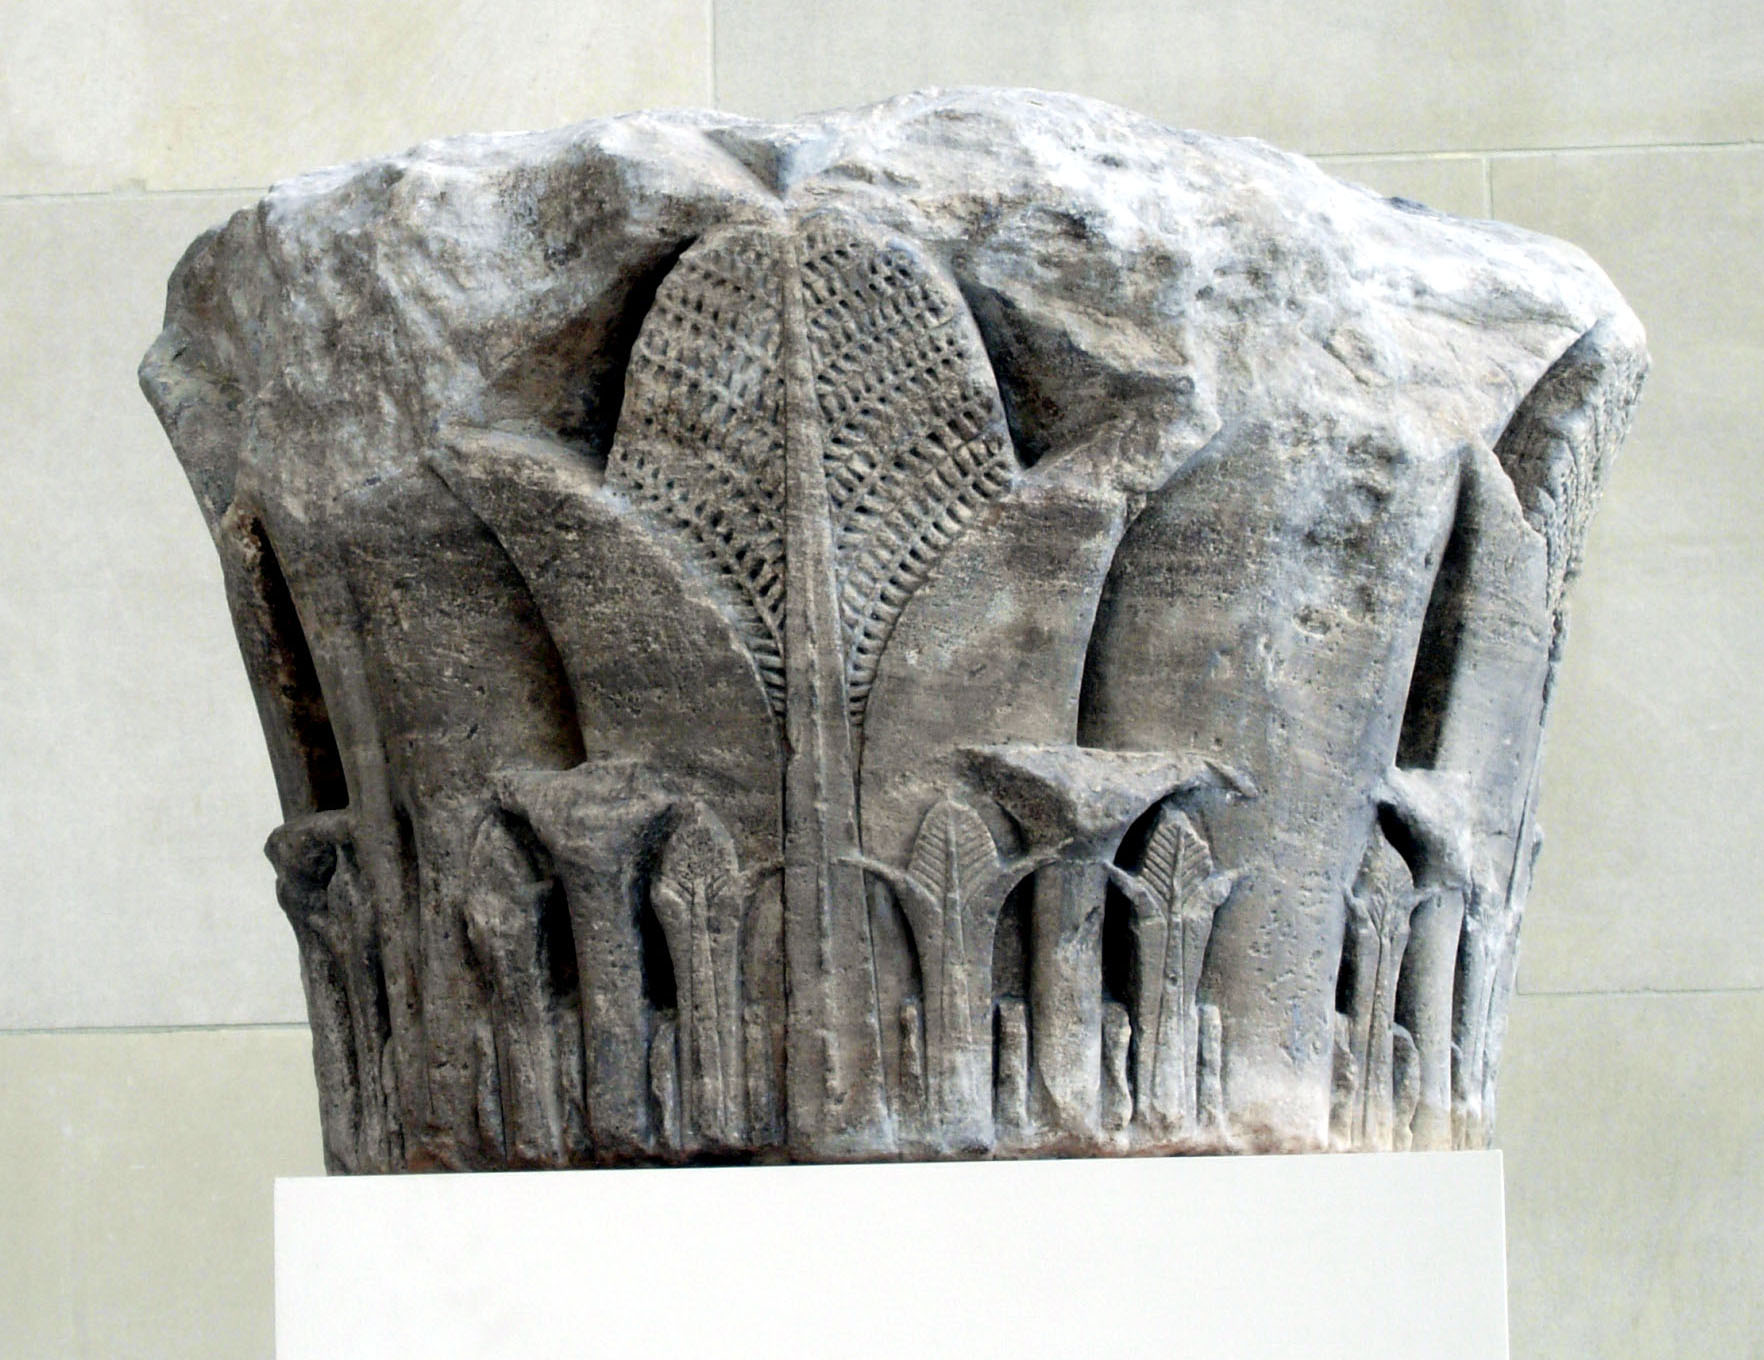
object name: column capital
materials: stone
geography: egypt